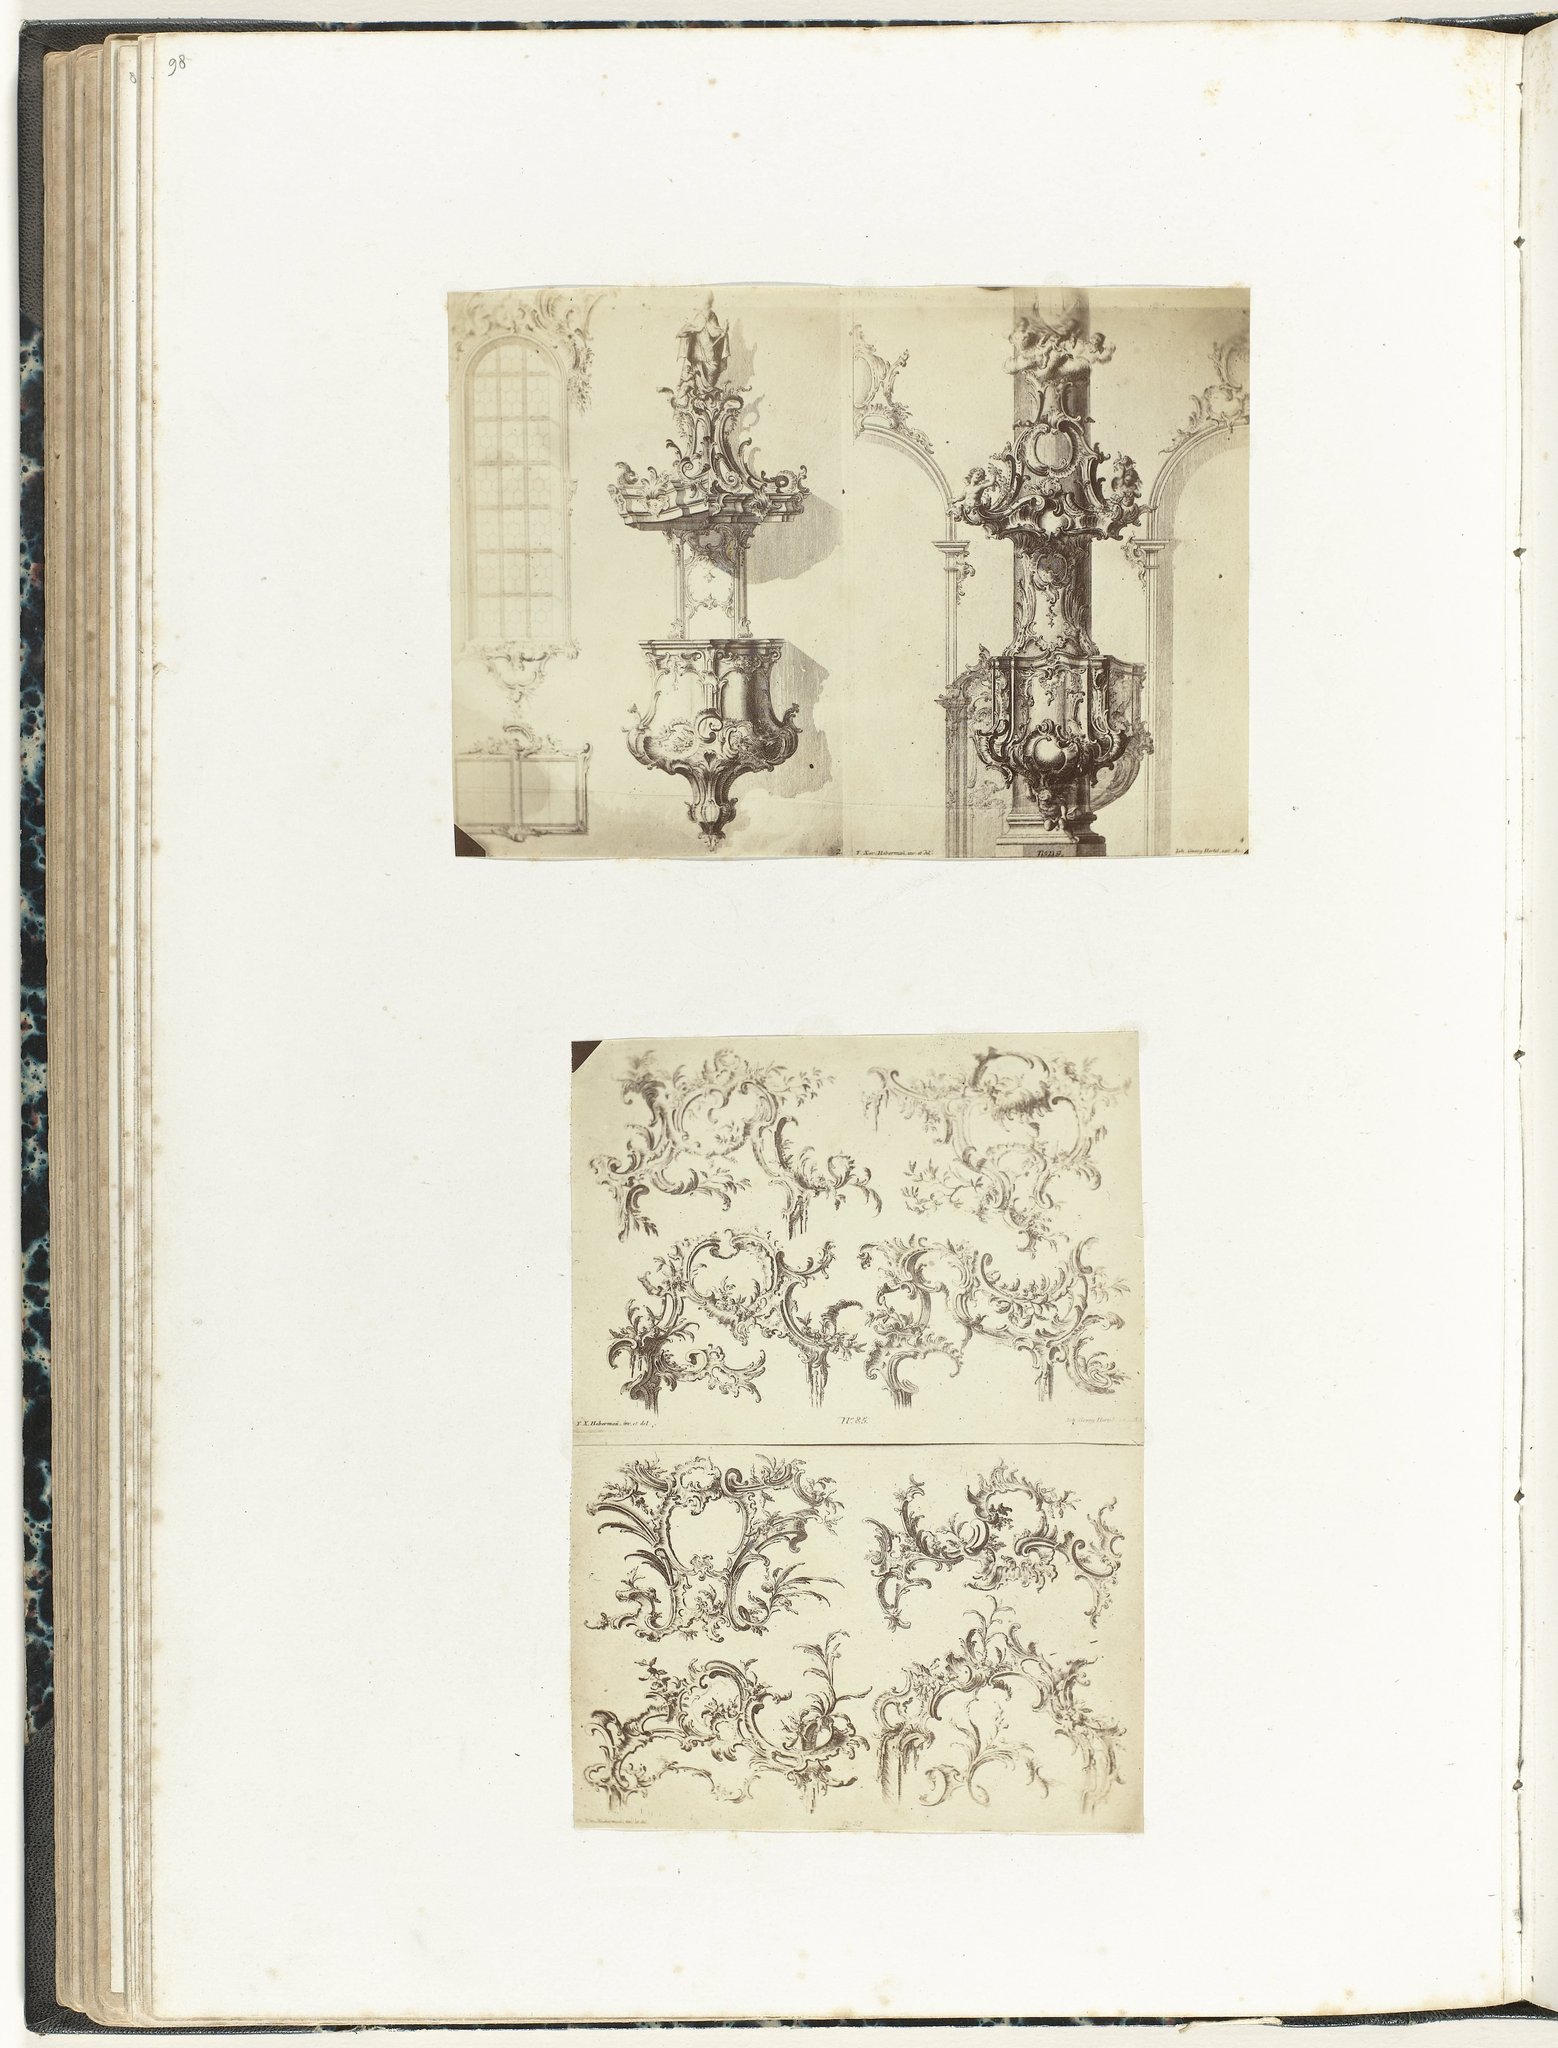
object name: photograph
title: Twee kansels en acht ornamenten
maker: Anonymous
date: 1866-1900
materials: paper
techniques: albumen print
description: Twee foto's van prenten van de ontwerper F. Xav. Haberman. Op de bovenste foto staan twee prenten met kansels, op de onderste twee prenten met grillige ornamenten.